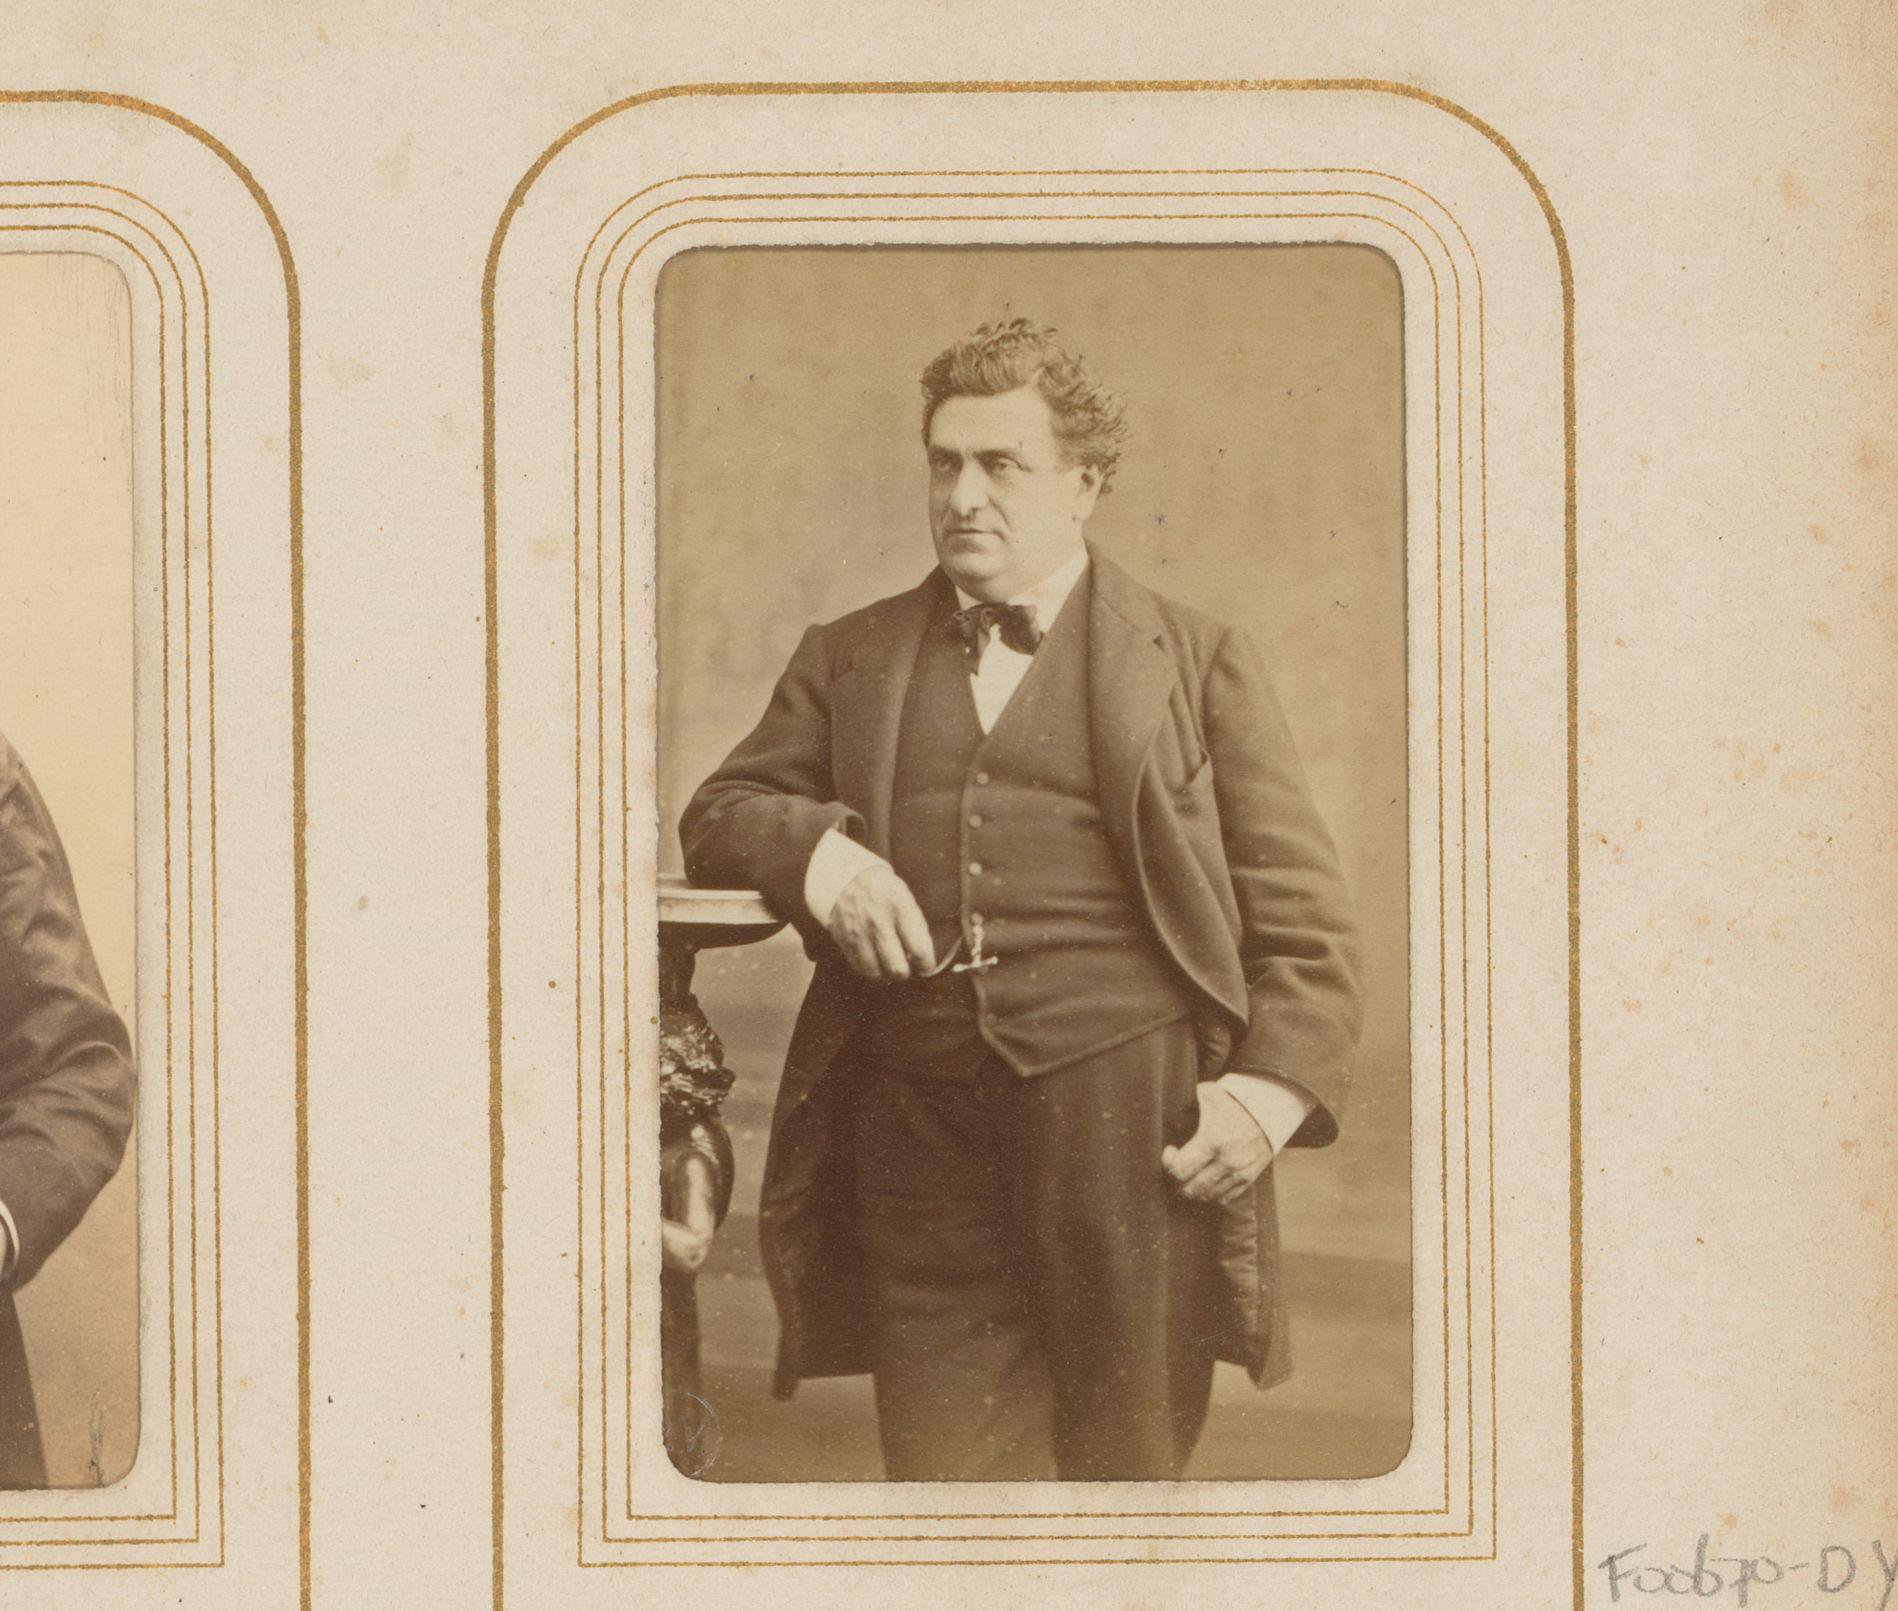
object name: album leaf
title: Portret van Talbot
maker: charles reutlinger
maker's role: publisher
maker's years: 1816-1880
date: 1870-1880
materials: cardboard, photographic support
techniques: albumen print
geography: paris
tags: historical persons, portrait of actor, actress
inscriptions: annotation: ‘Talbot/ fr./ acteur [...] 1856’, annotation: ‘Talbot fr. acteur (Reutlinger)’, inscription: ‘Ch. Reutlinger/ Photographe/ 21, Boulevard Montmarte, 21/ Paris (...)’